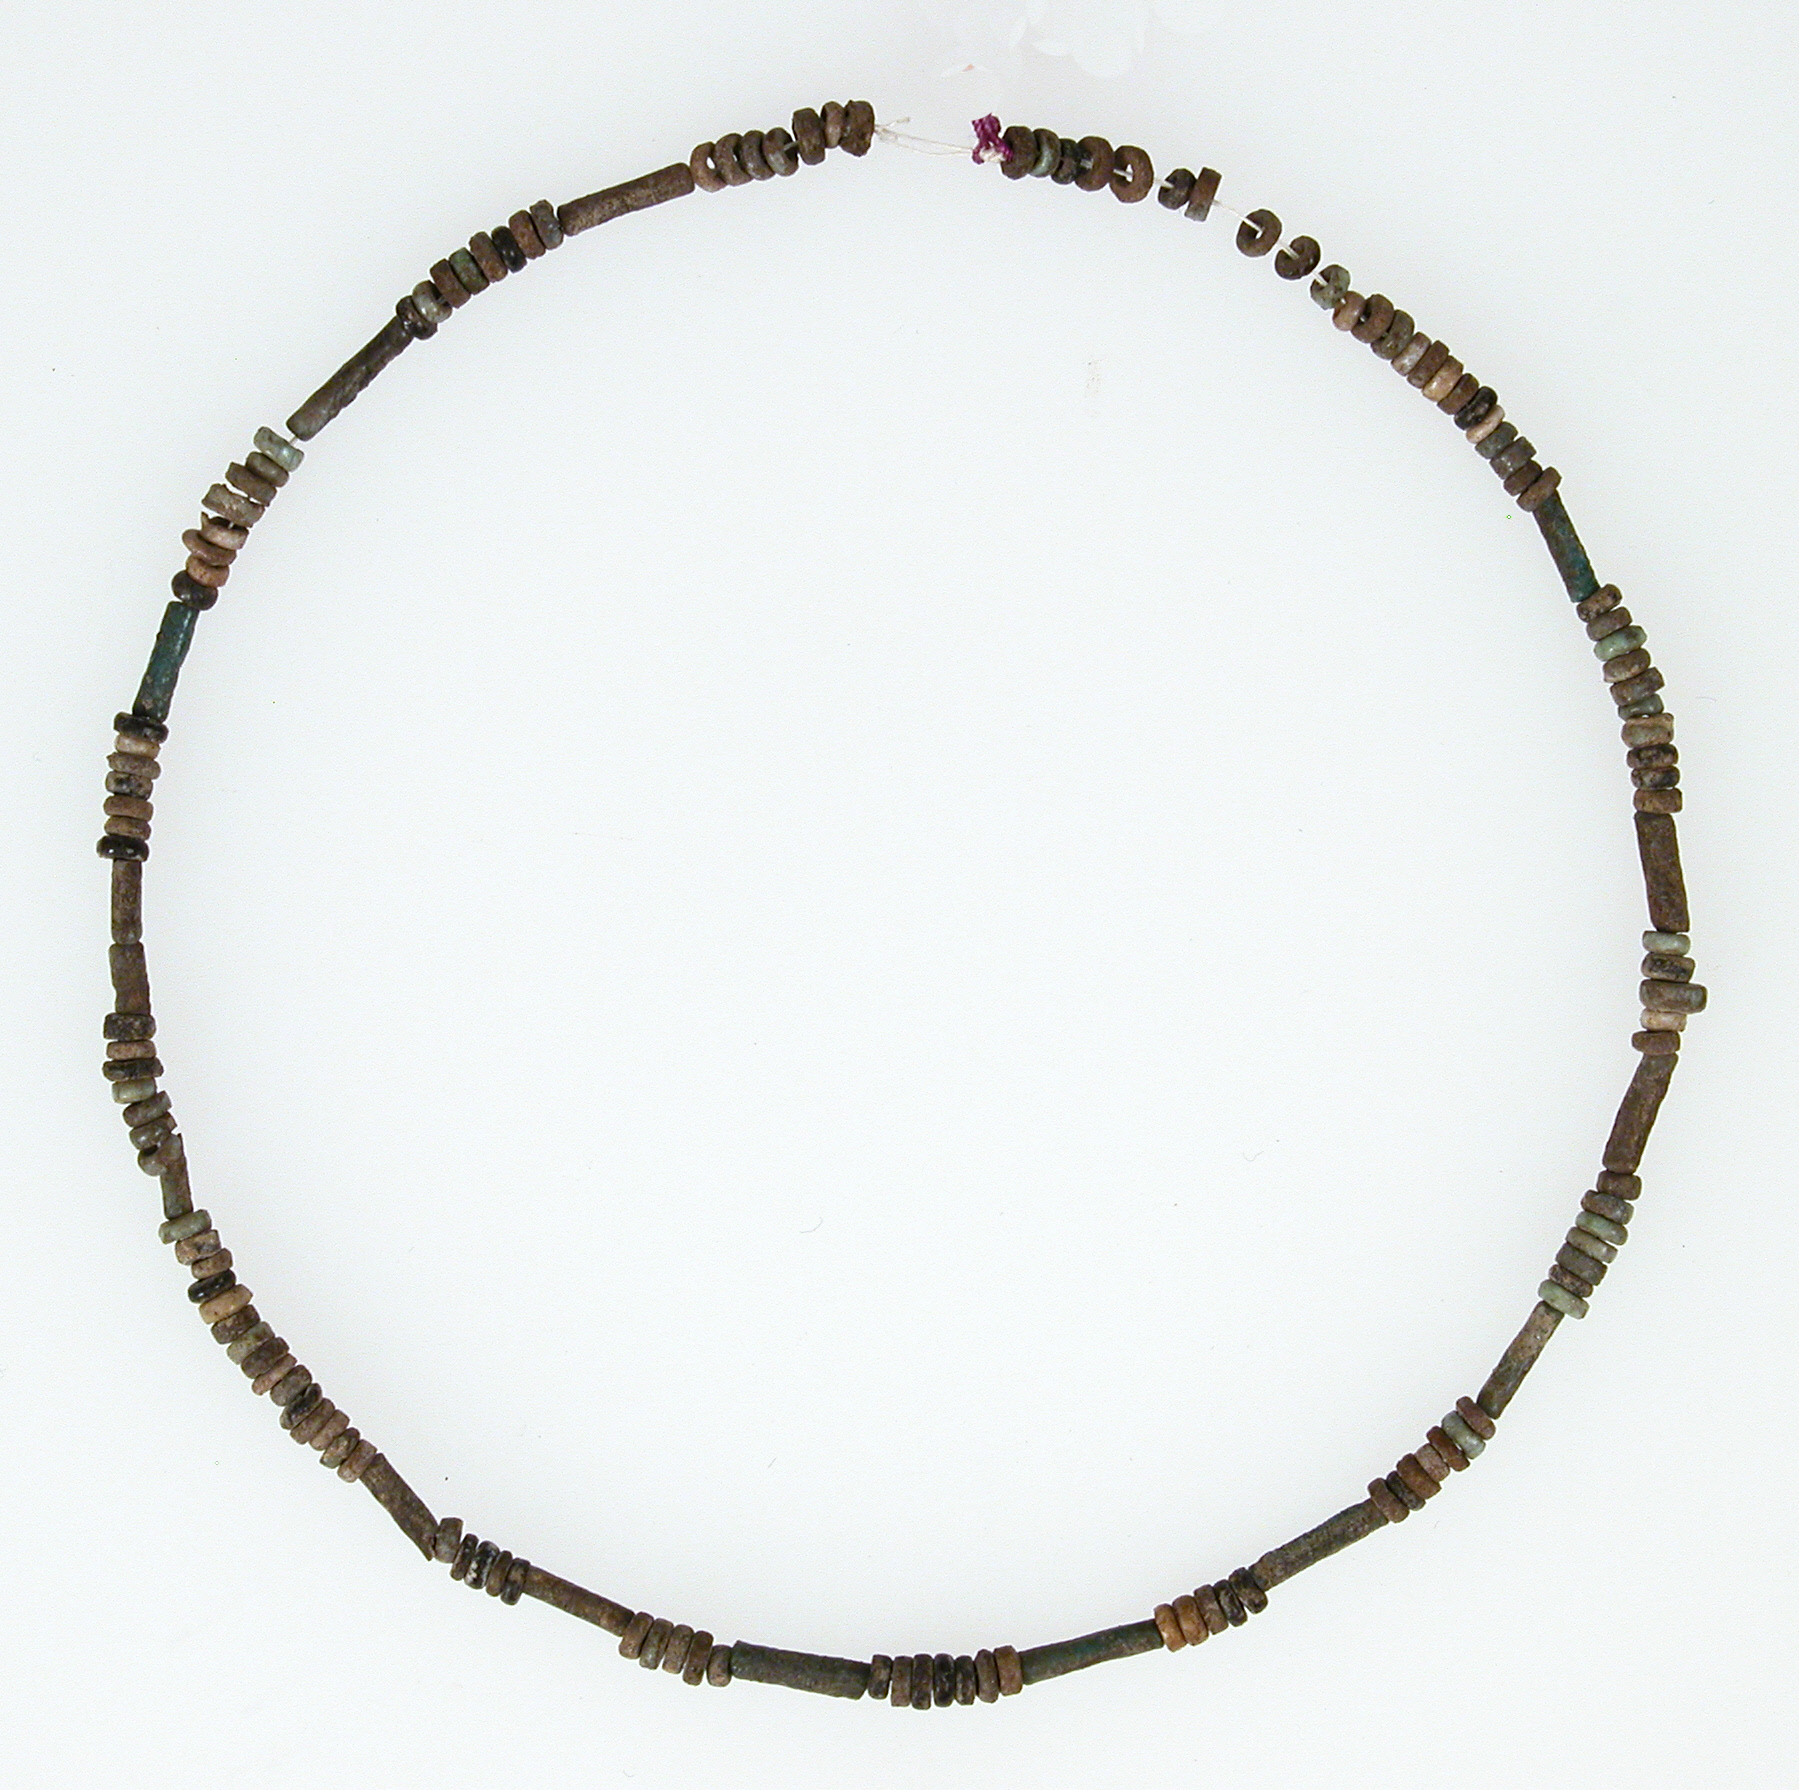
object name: bead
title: String of Beads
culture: coptic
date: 301-700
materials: earthenware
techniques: glazing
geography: egypt